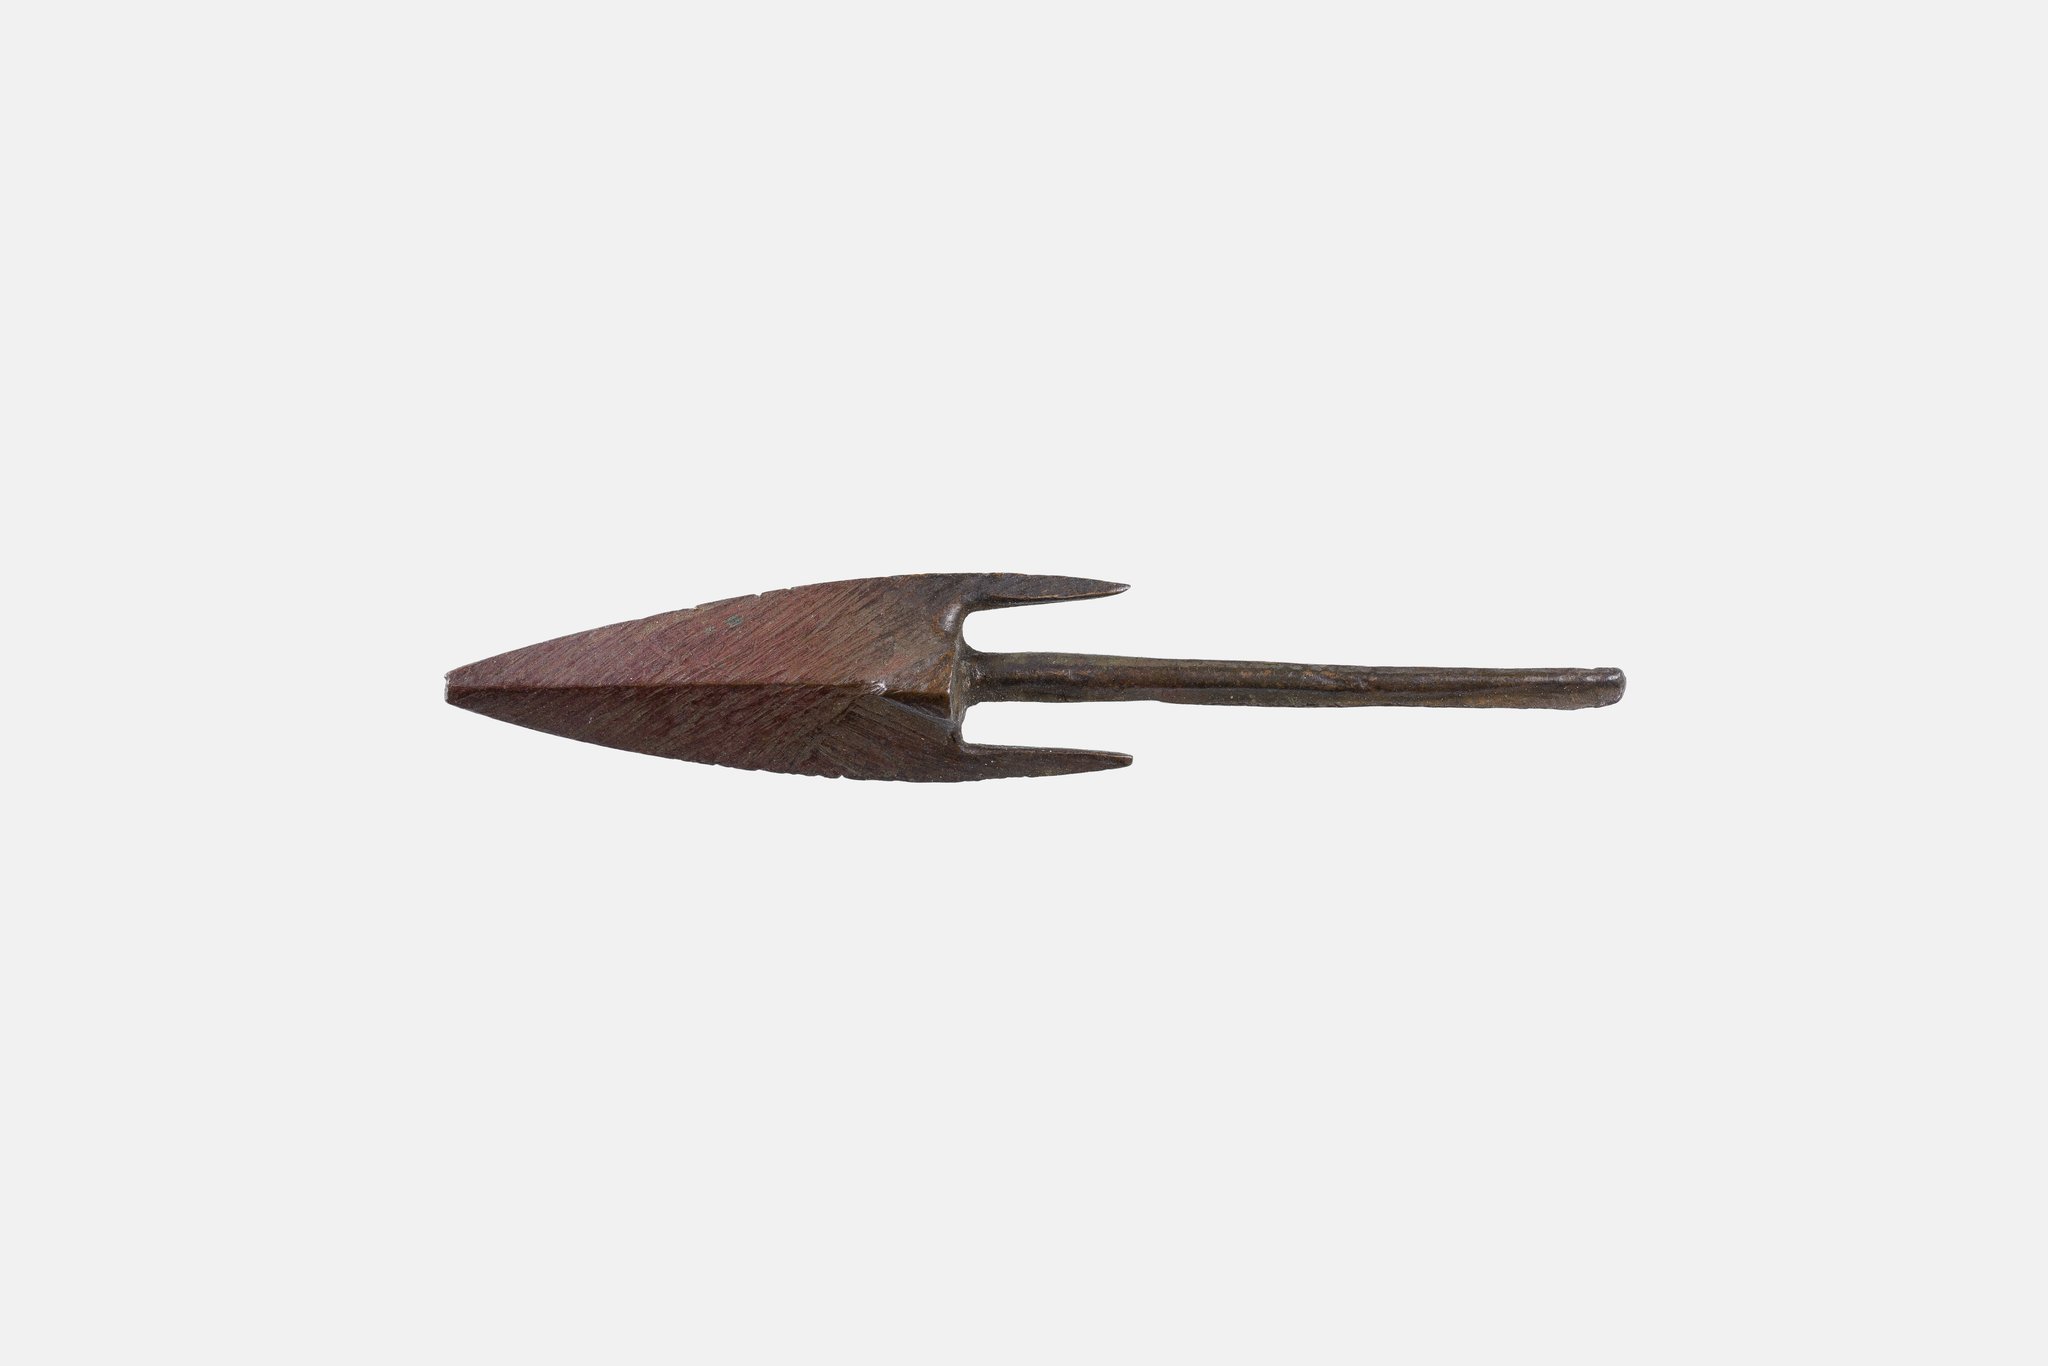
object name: arrowhead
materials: iron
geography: egypt